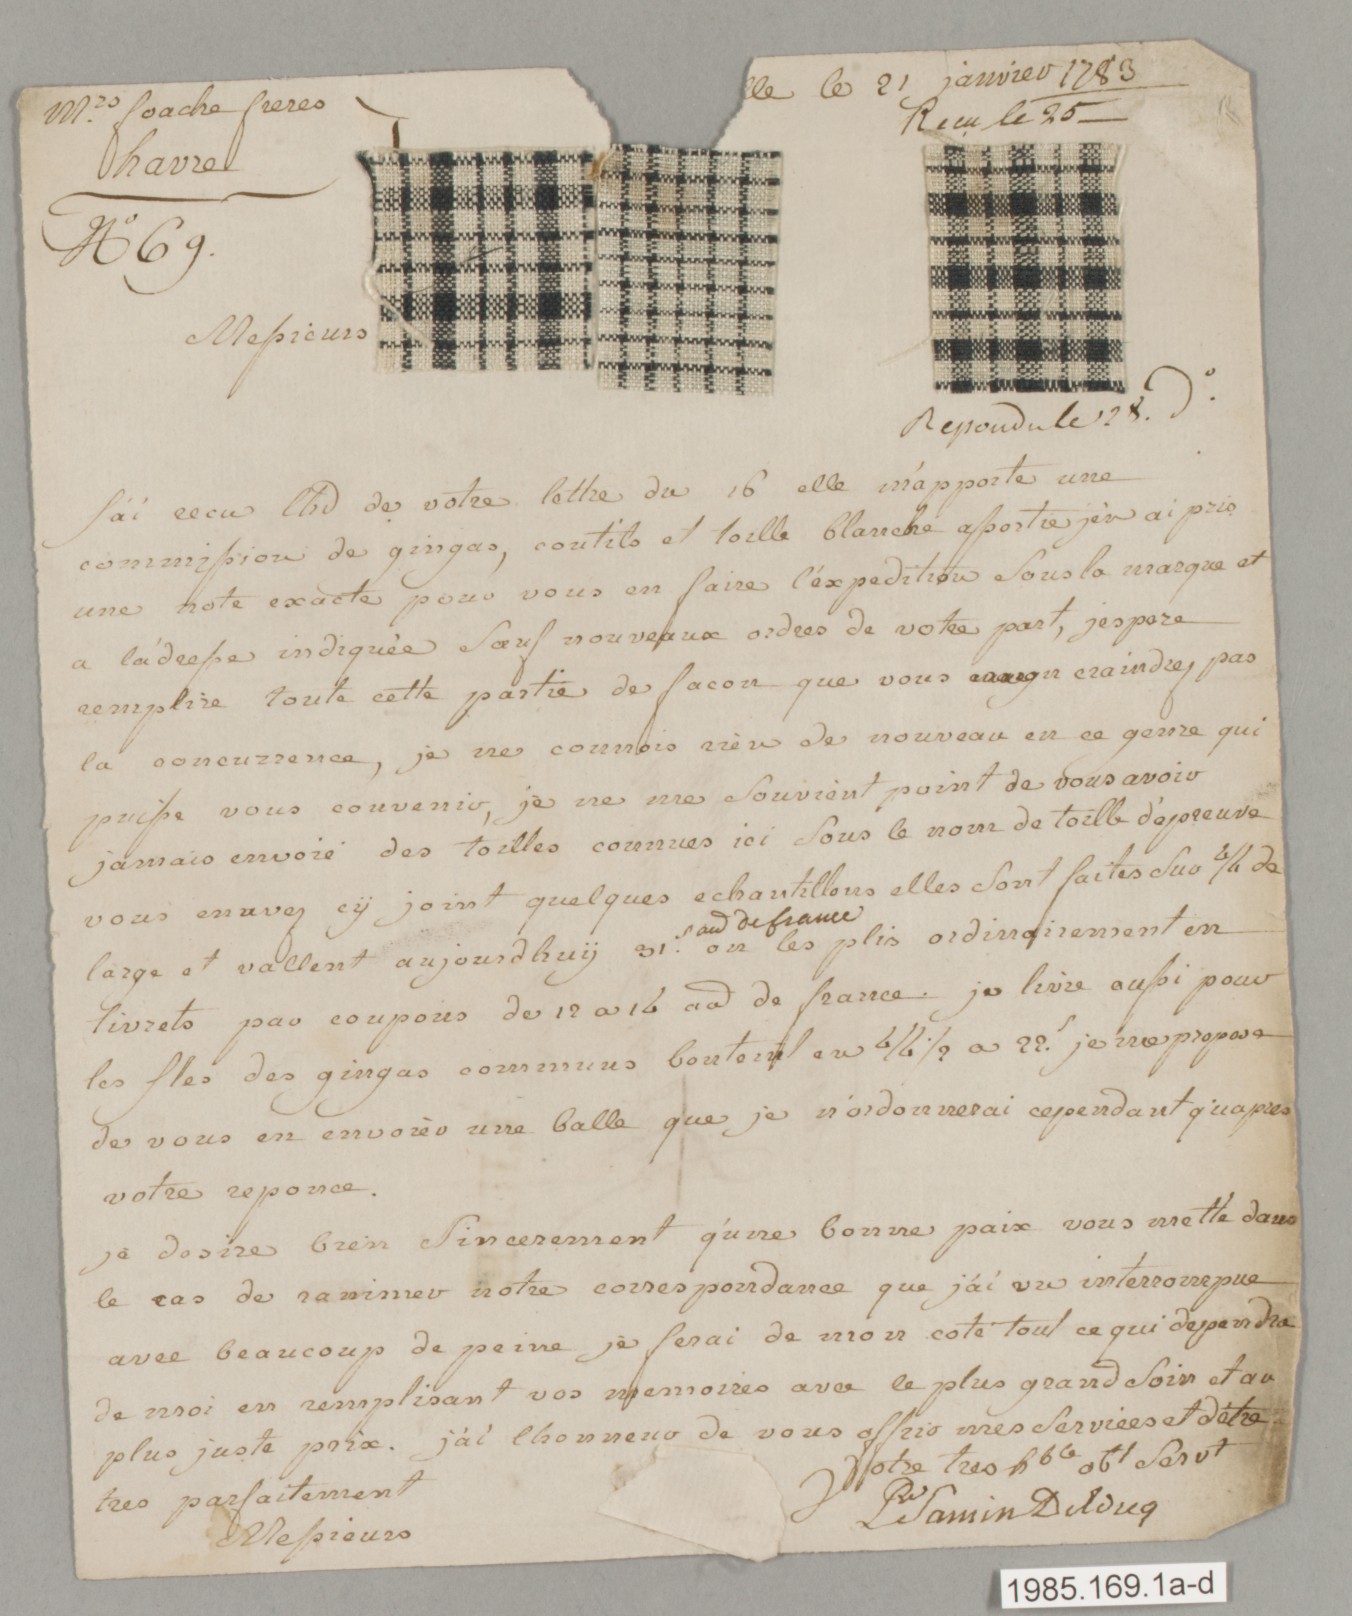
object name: letter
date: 1767-1833